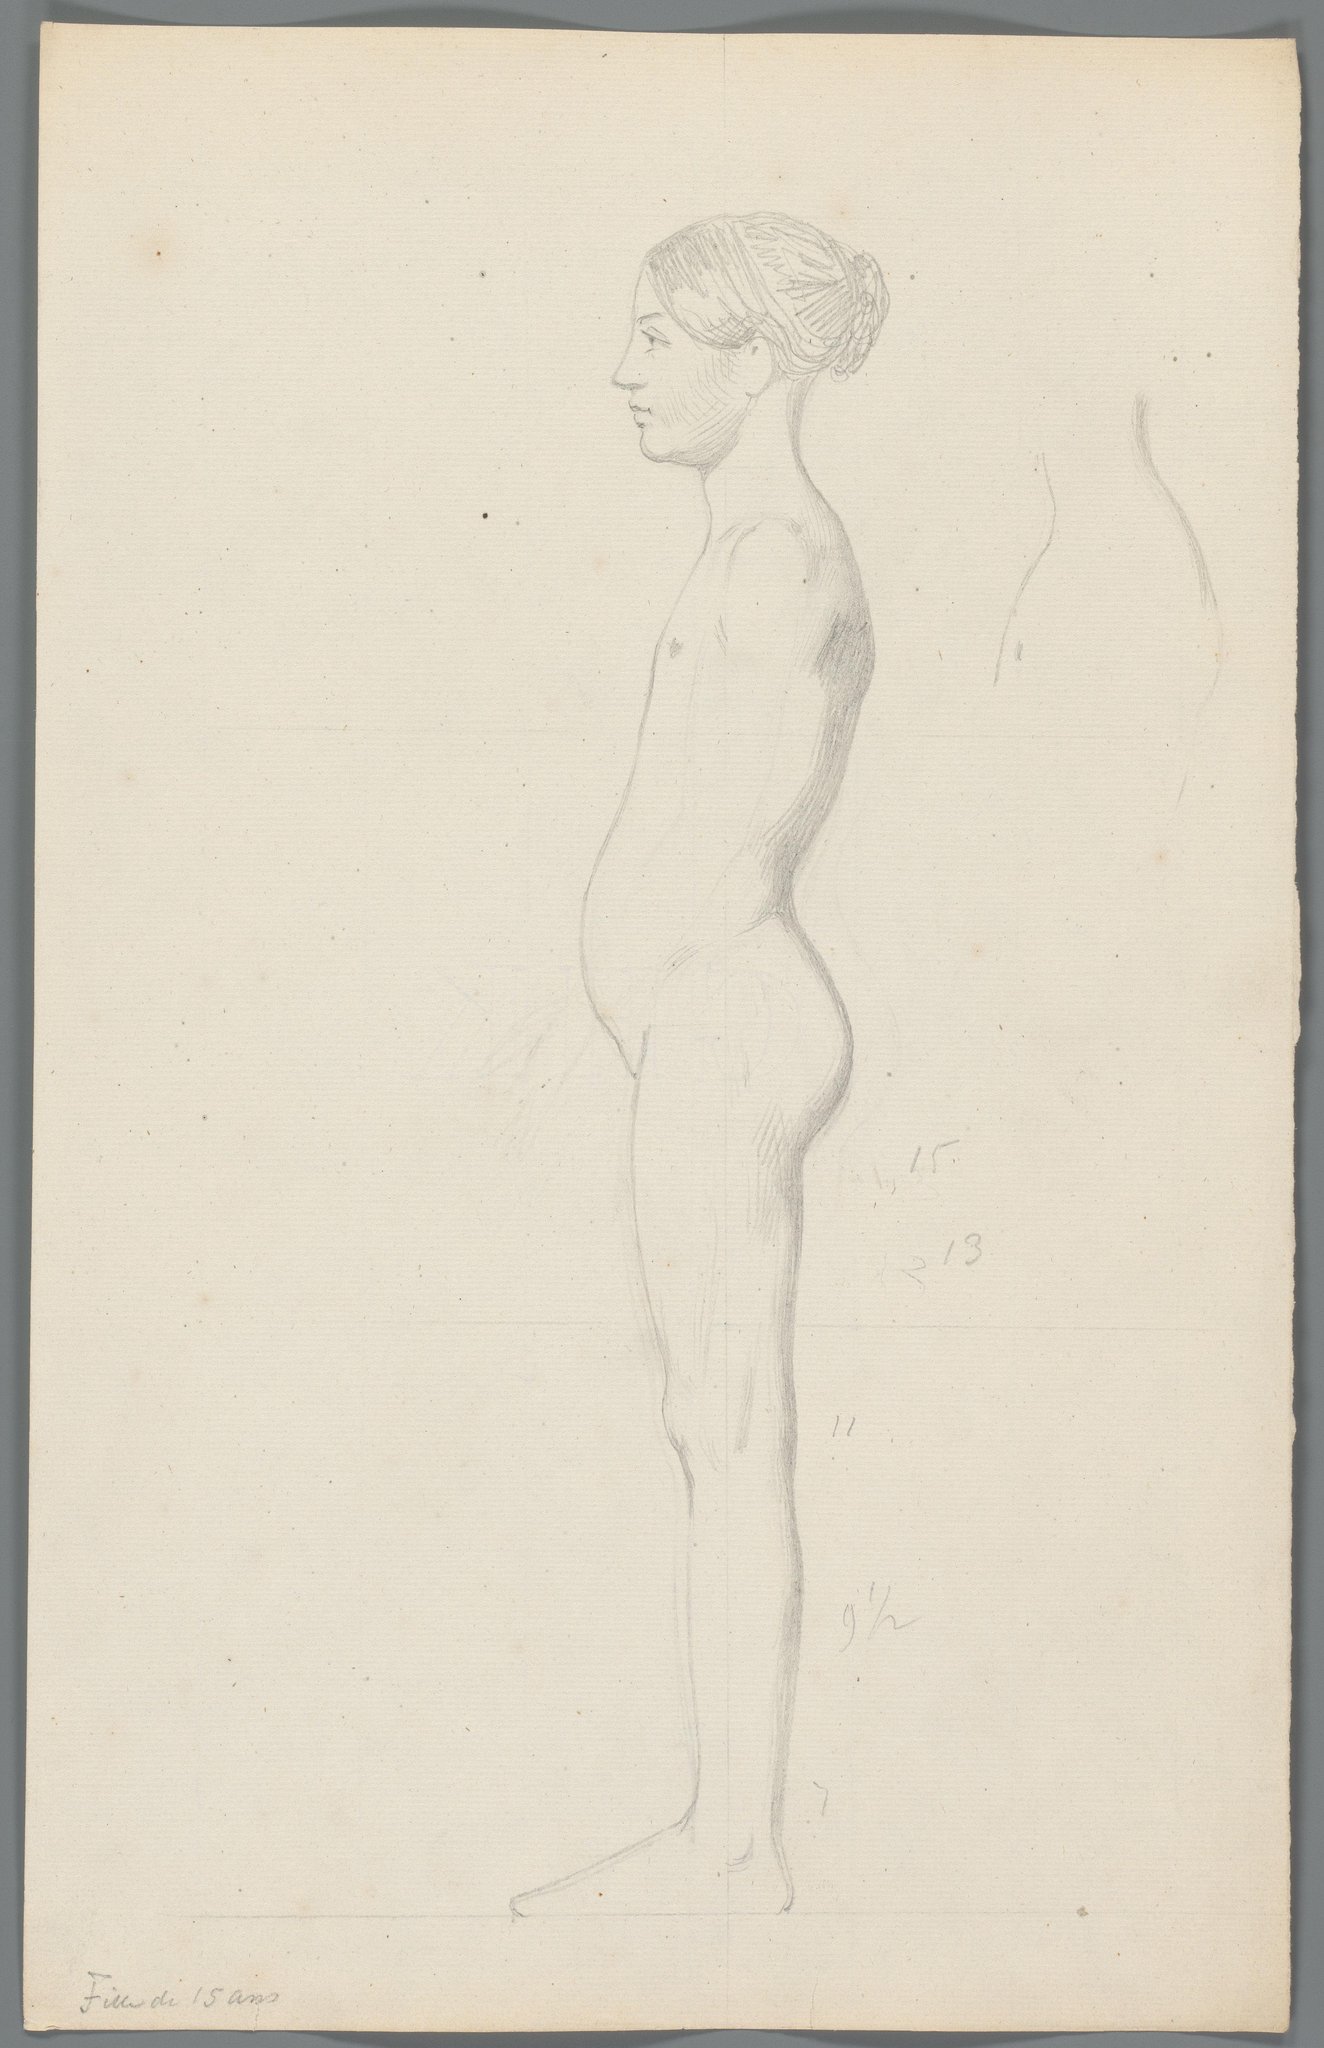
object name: drawing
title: Proportiestudie van een meisje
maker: jacobus everhardus josephus van den berg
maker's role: draughtsman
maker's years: 1802-1861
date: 1812-1861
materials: paper, pencil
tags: standing figure (canon, proportions) - aa - female human figure, child (at home) - aa - girl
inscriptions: inscription: ‘Fille de 15 ans’